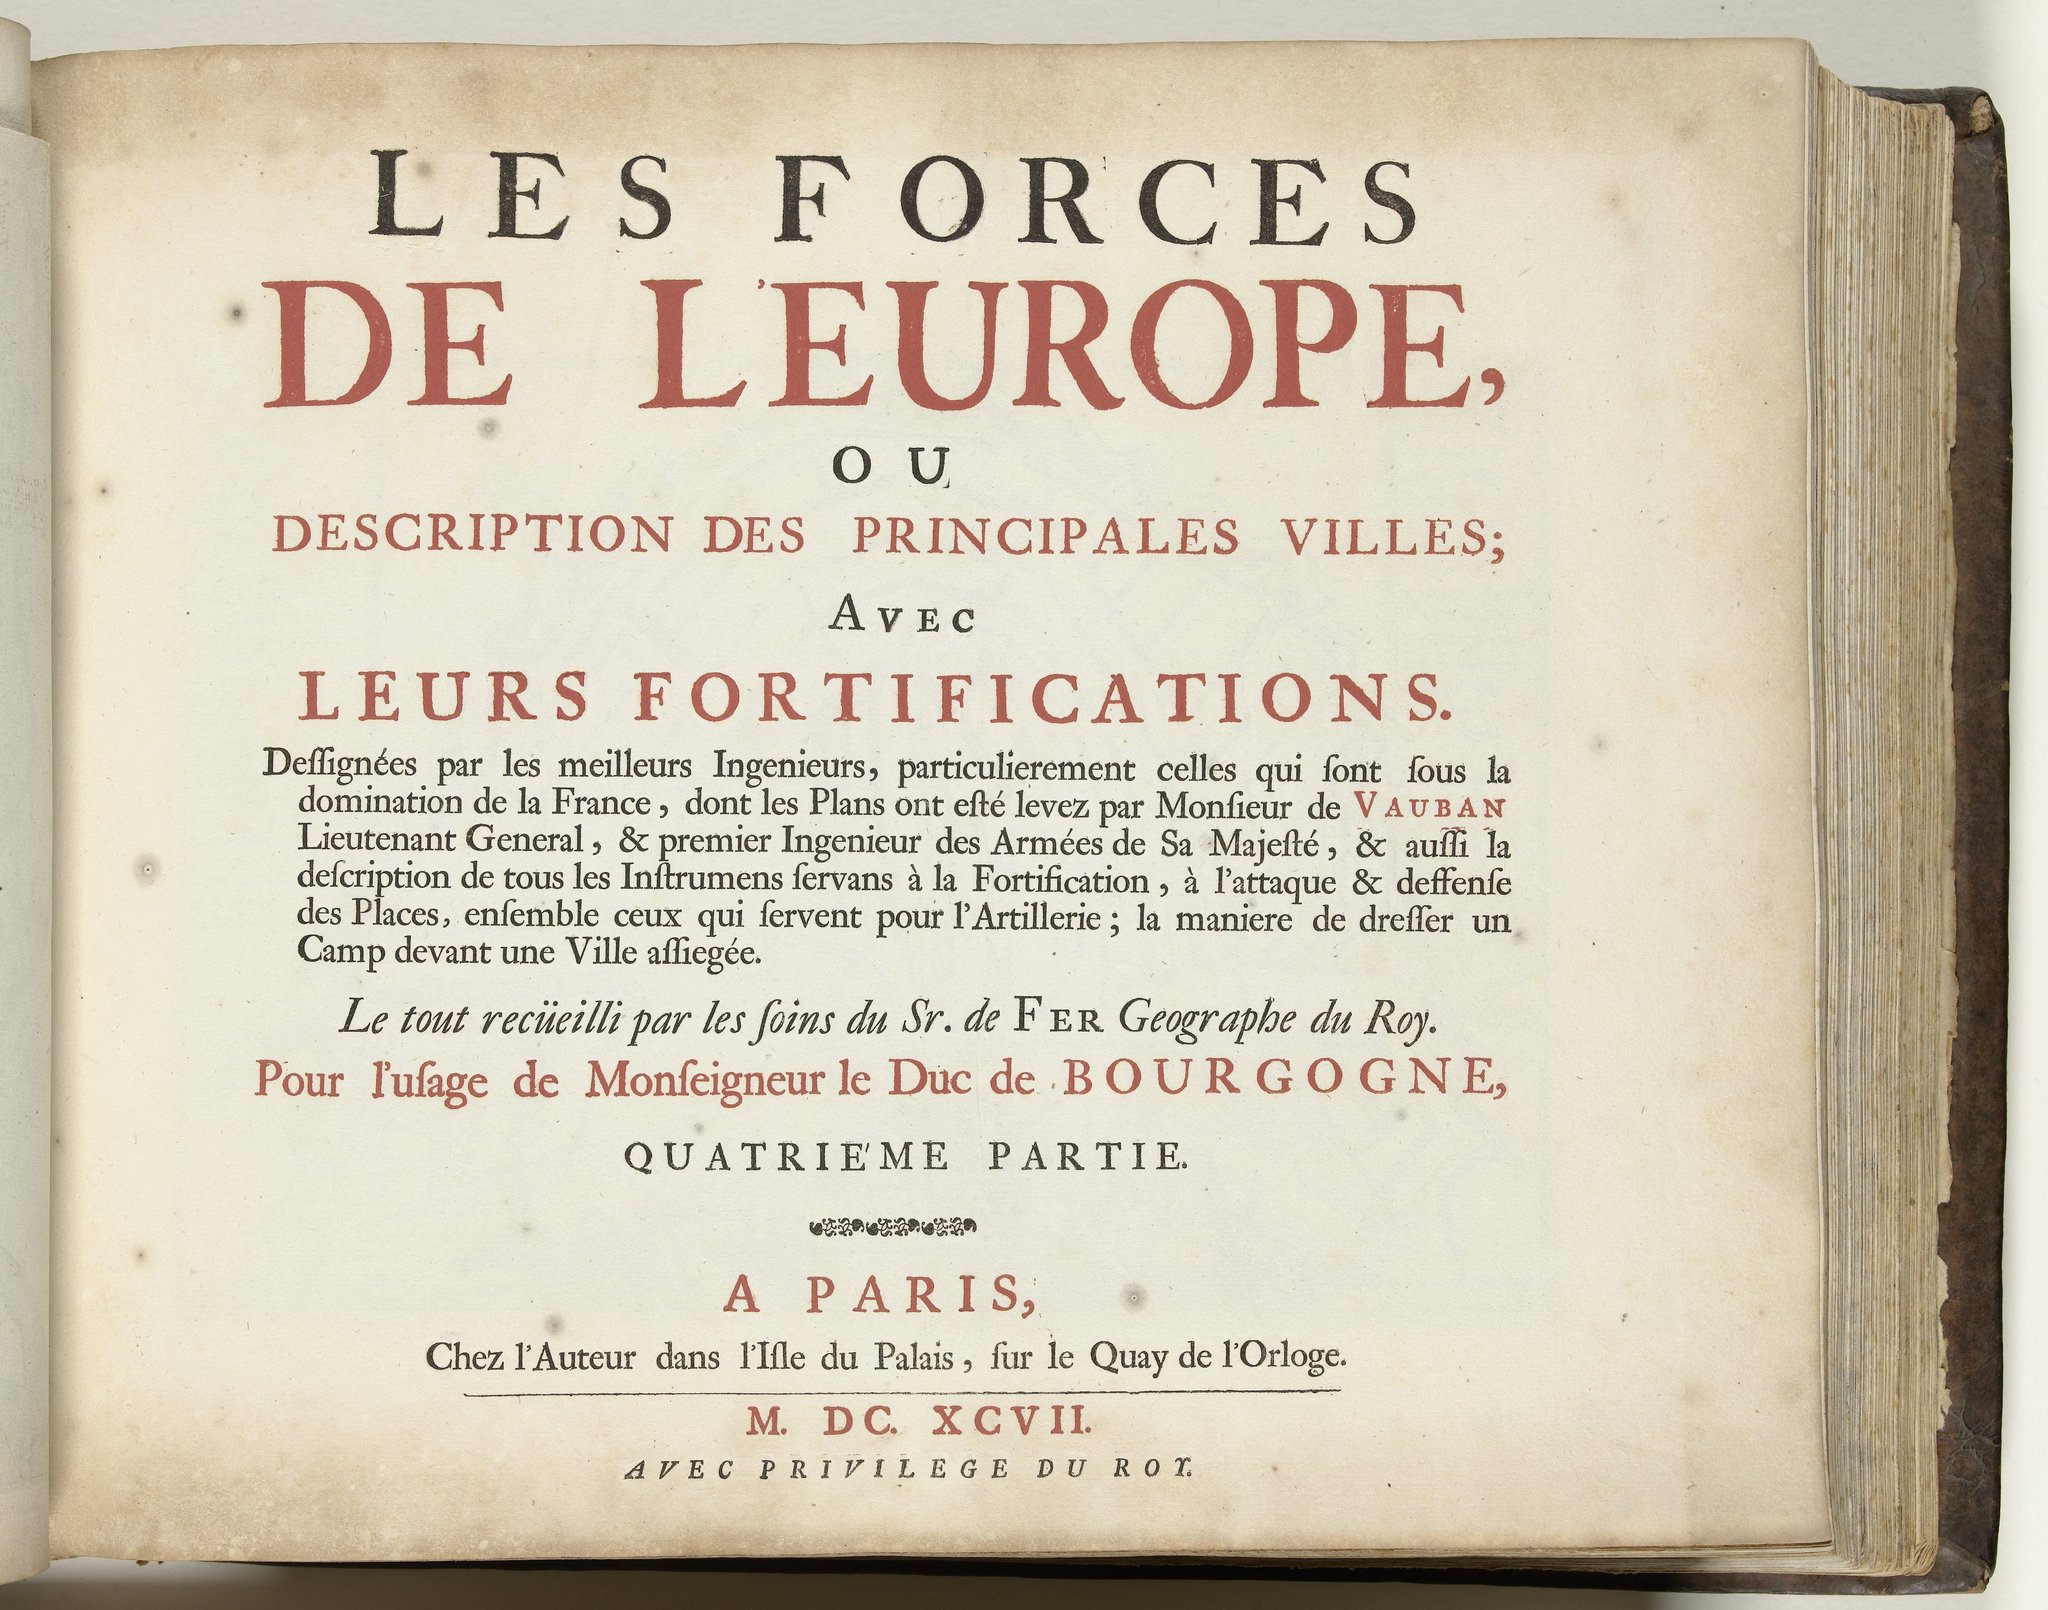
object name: titelblad, titelpagina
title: Les forces de l'Europe, ou description des principales villes, avec leurs fortifications : dessignées par les meilleurs ingenieurs, particulierement celles (...) de la France, dont les plans ont esté levez par M. de Vauban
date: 1697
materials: paper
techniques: letterpress printing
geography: paris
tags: negenjarige oorlog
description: Titelpagina uit 1697 gedrukt in zwart en rood voor het vierde deel van het prentwerk waarin gebundeld zijn de acht delen van Les forces de l'Europe uitgegeven tussen 1693-1697. Het prentwerk bestaat uit 175 platen met plannen (afkomstig van Sébastien Le Prestre, Seigneur de Vauban) van vermaarde sterke steden en vestingen in de Negenjarige Oorlog. Titel in het Frans.